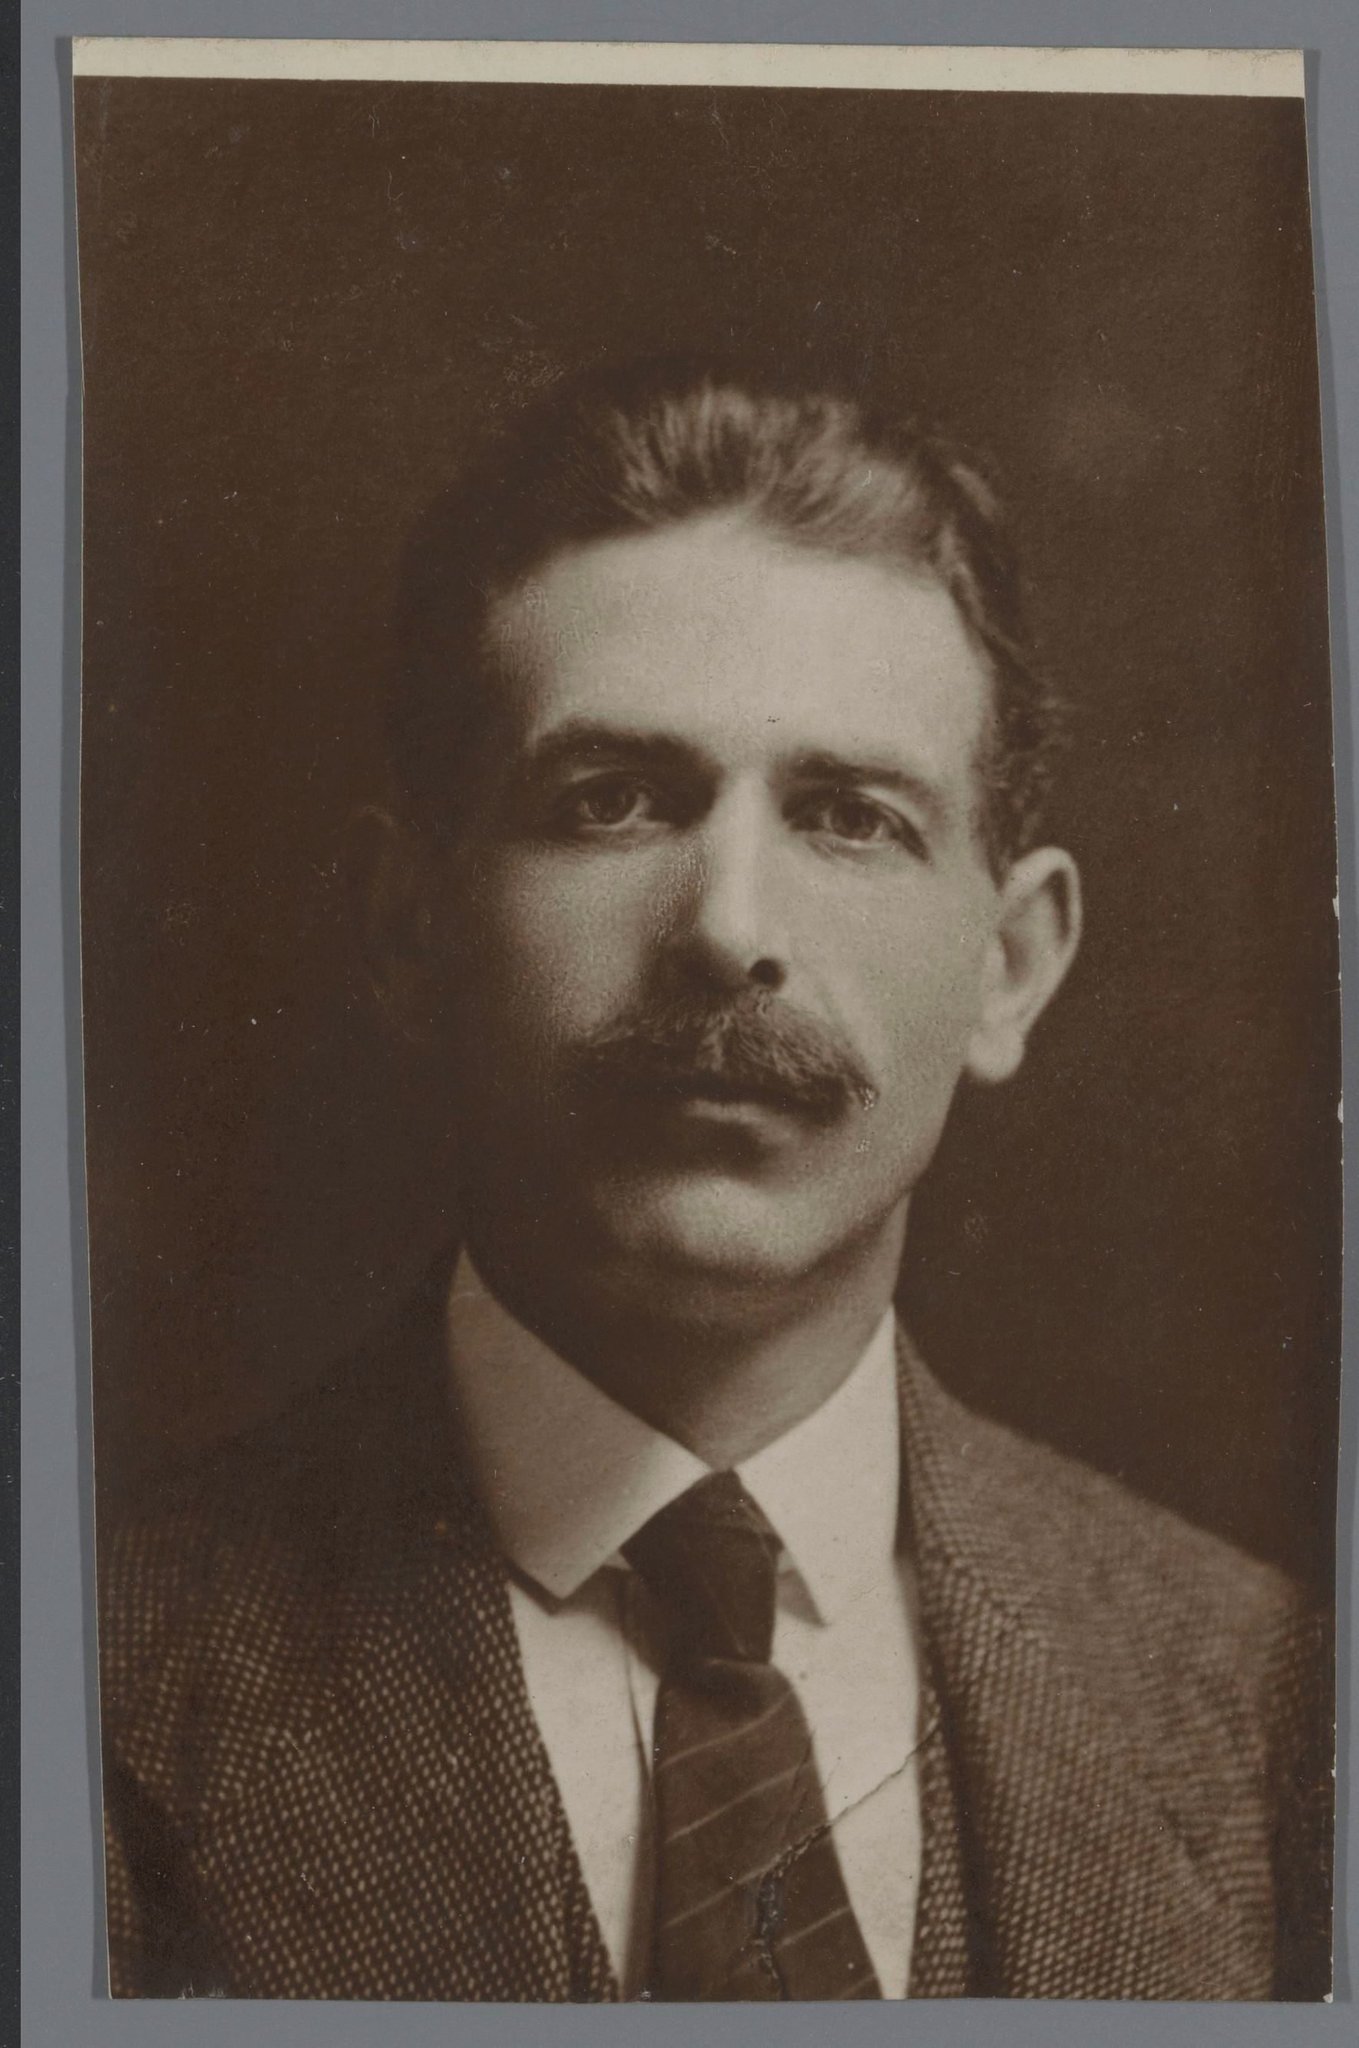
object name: photograph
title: Portret van een onbekende man met een snor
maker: Anonymous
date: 1920-1940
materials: photographic support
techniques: gelatin silver print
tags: adult man